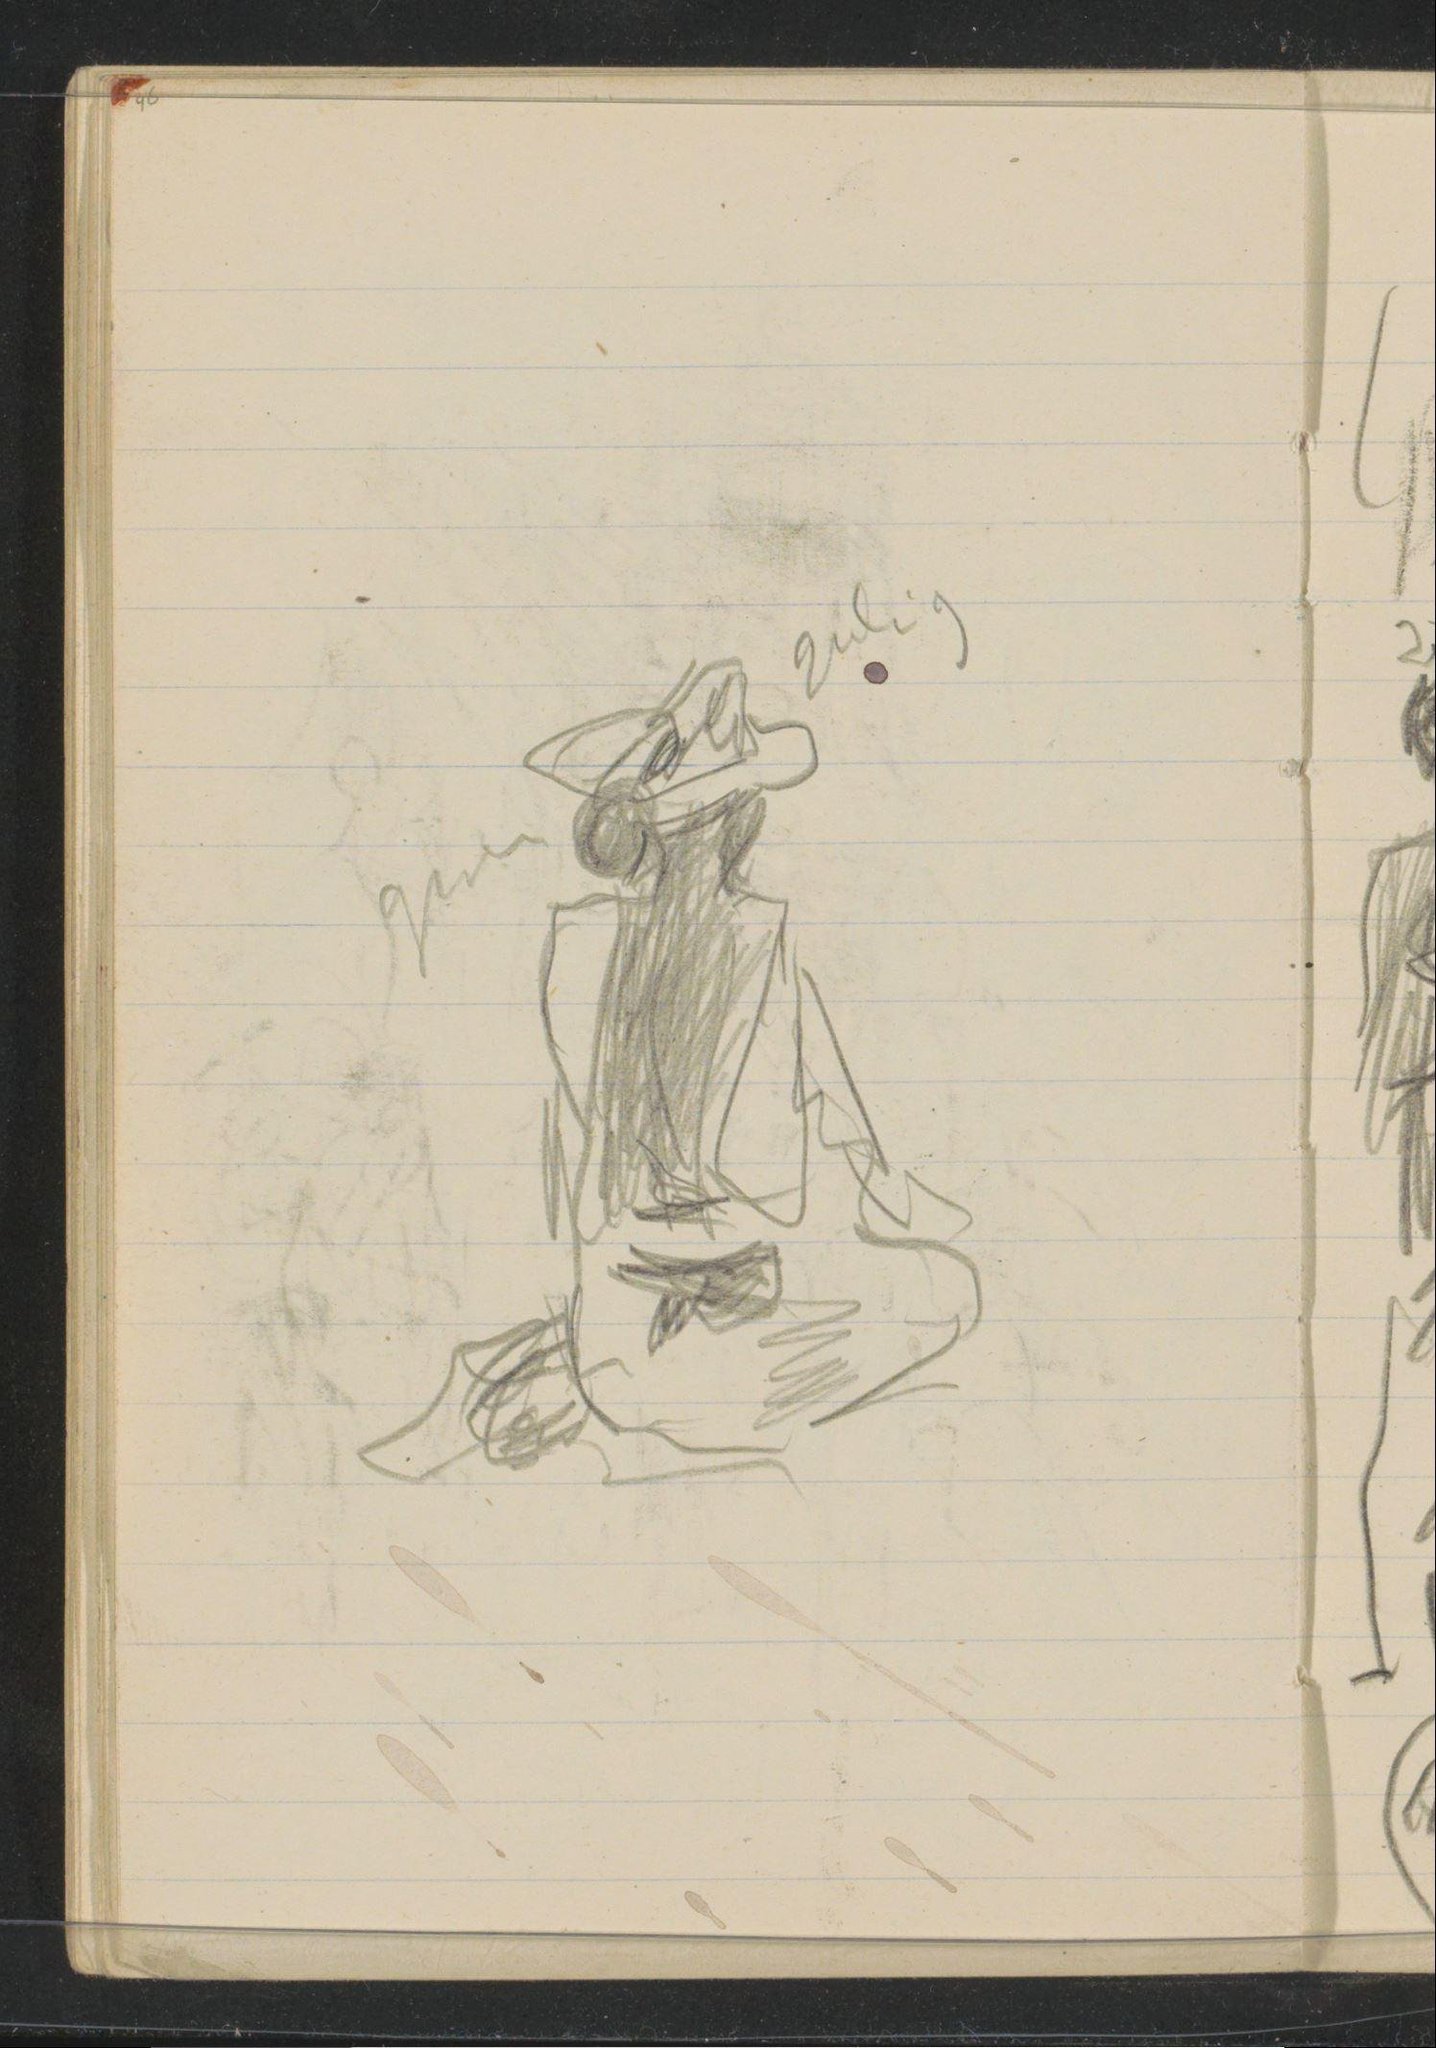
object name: sketchbook leaf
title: Zittende Indonesische vrouw, op de rug gezien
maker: marius bauer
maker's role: draughtsman, print maker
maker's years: 1867-1932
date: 1931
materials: pencil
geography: indonesia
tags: asiatic races and peoples, sitting figure, adult woman, folk costume, regional costume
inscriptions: kleurnotitie, handgeschreven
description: Pagina 46 uit een schetsboek met 74 bladen.